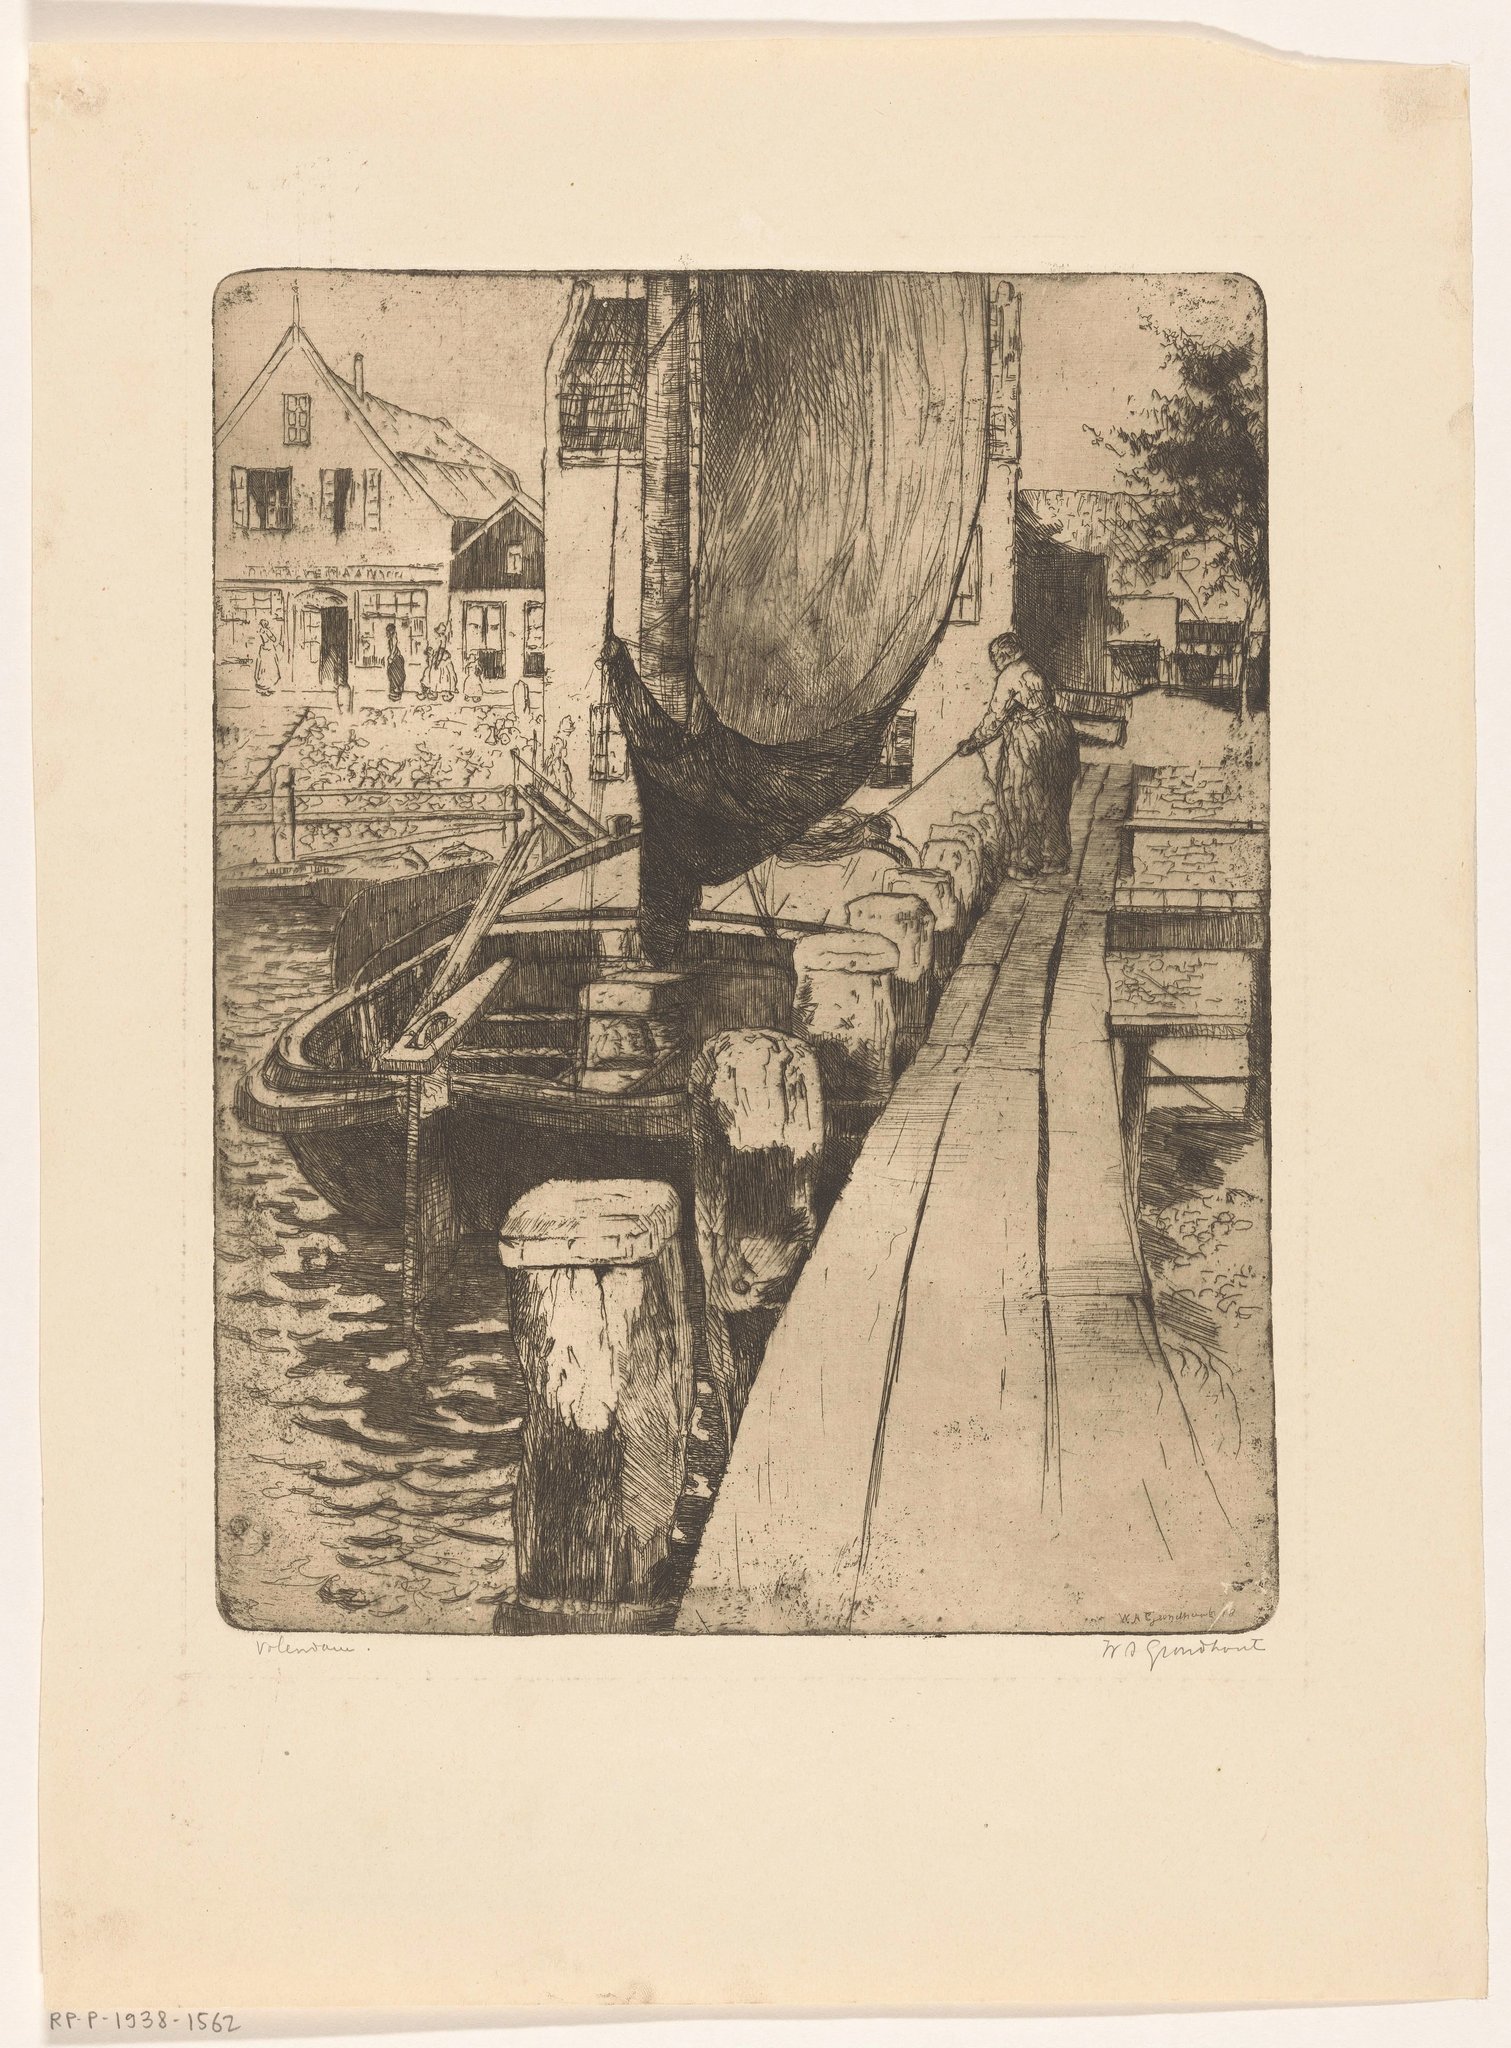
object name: print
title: Volendam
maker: willem adrianus grondhout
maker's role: draughtsman, painter, print maker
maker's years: 1878-1934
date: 1888-1934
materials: paper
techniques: etching, intaglio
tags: harbour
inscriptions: collector's mark: Lugt 2228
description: Een afgemeerde botter in de haven van Volendam.